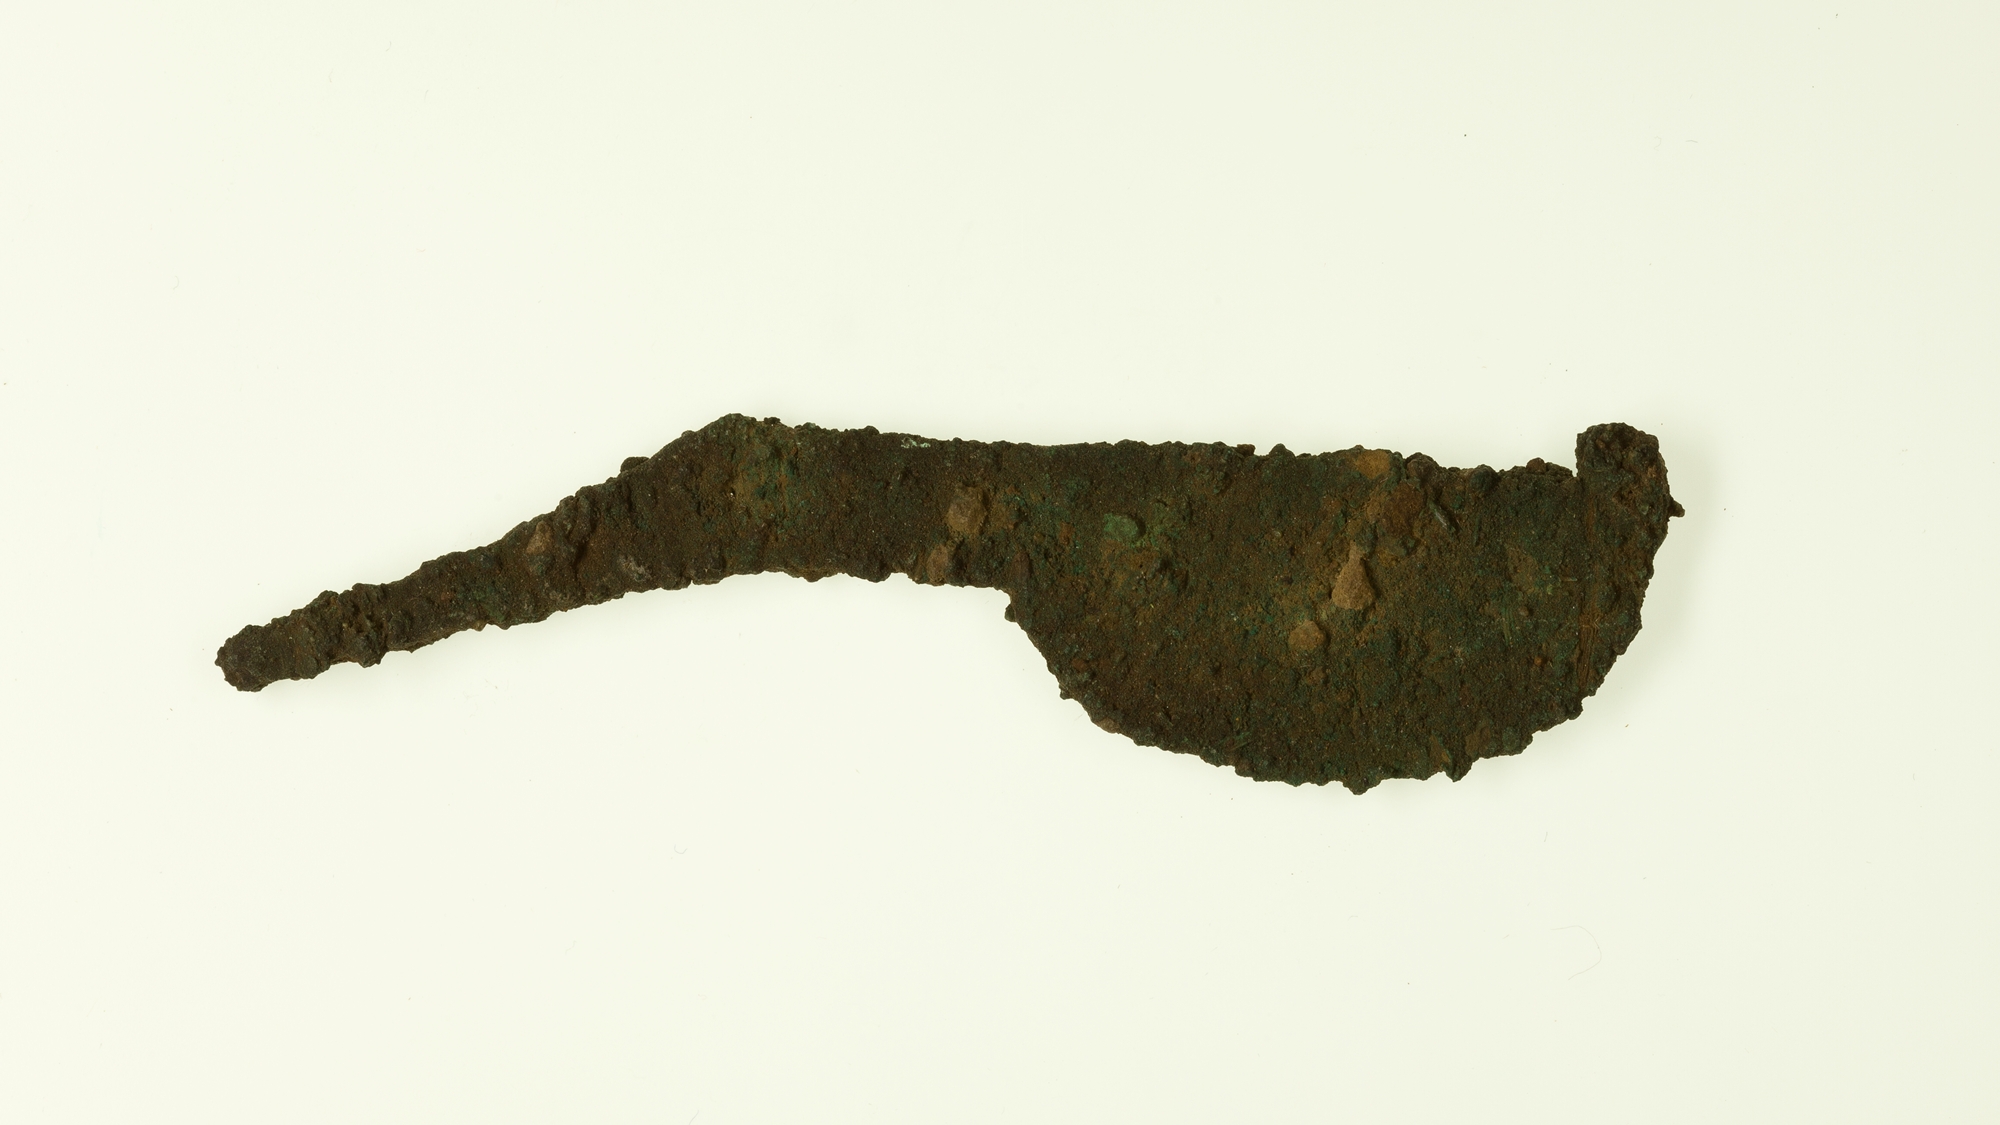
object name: scribe's knife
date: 1295-1070 BCE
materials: bronze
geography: egypt